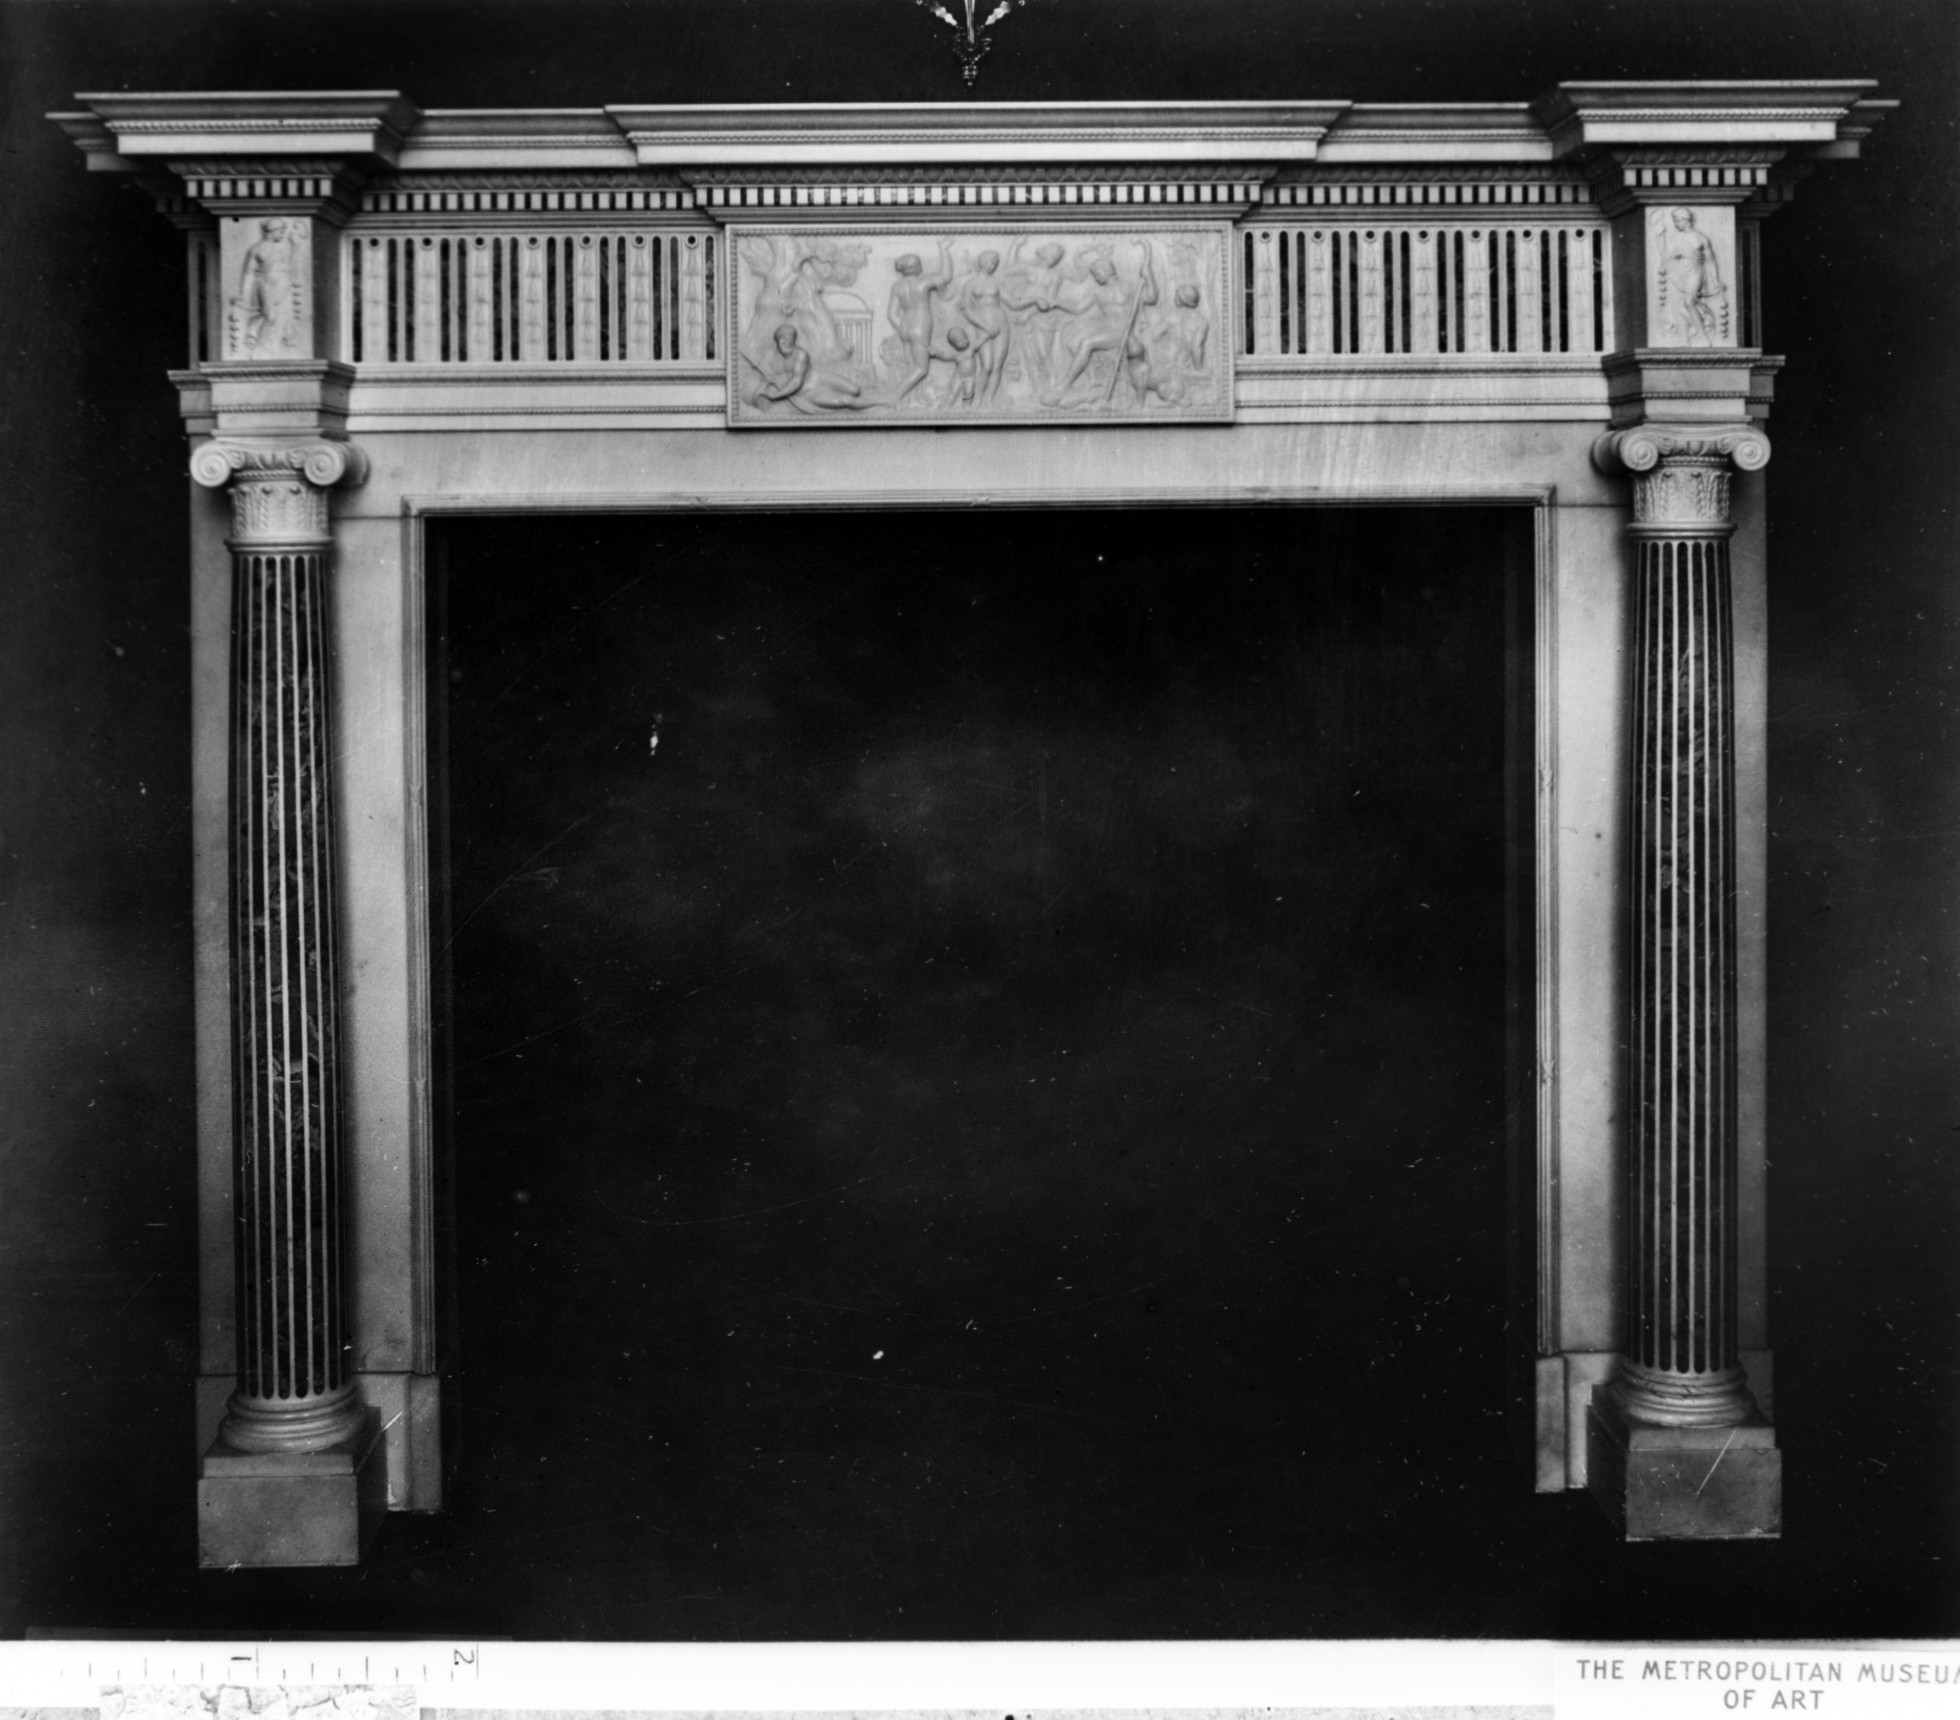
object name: mantelpiece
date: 1770-1780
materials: marble